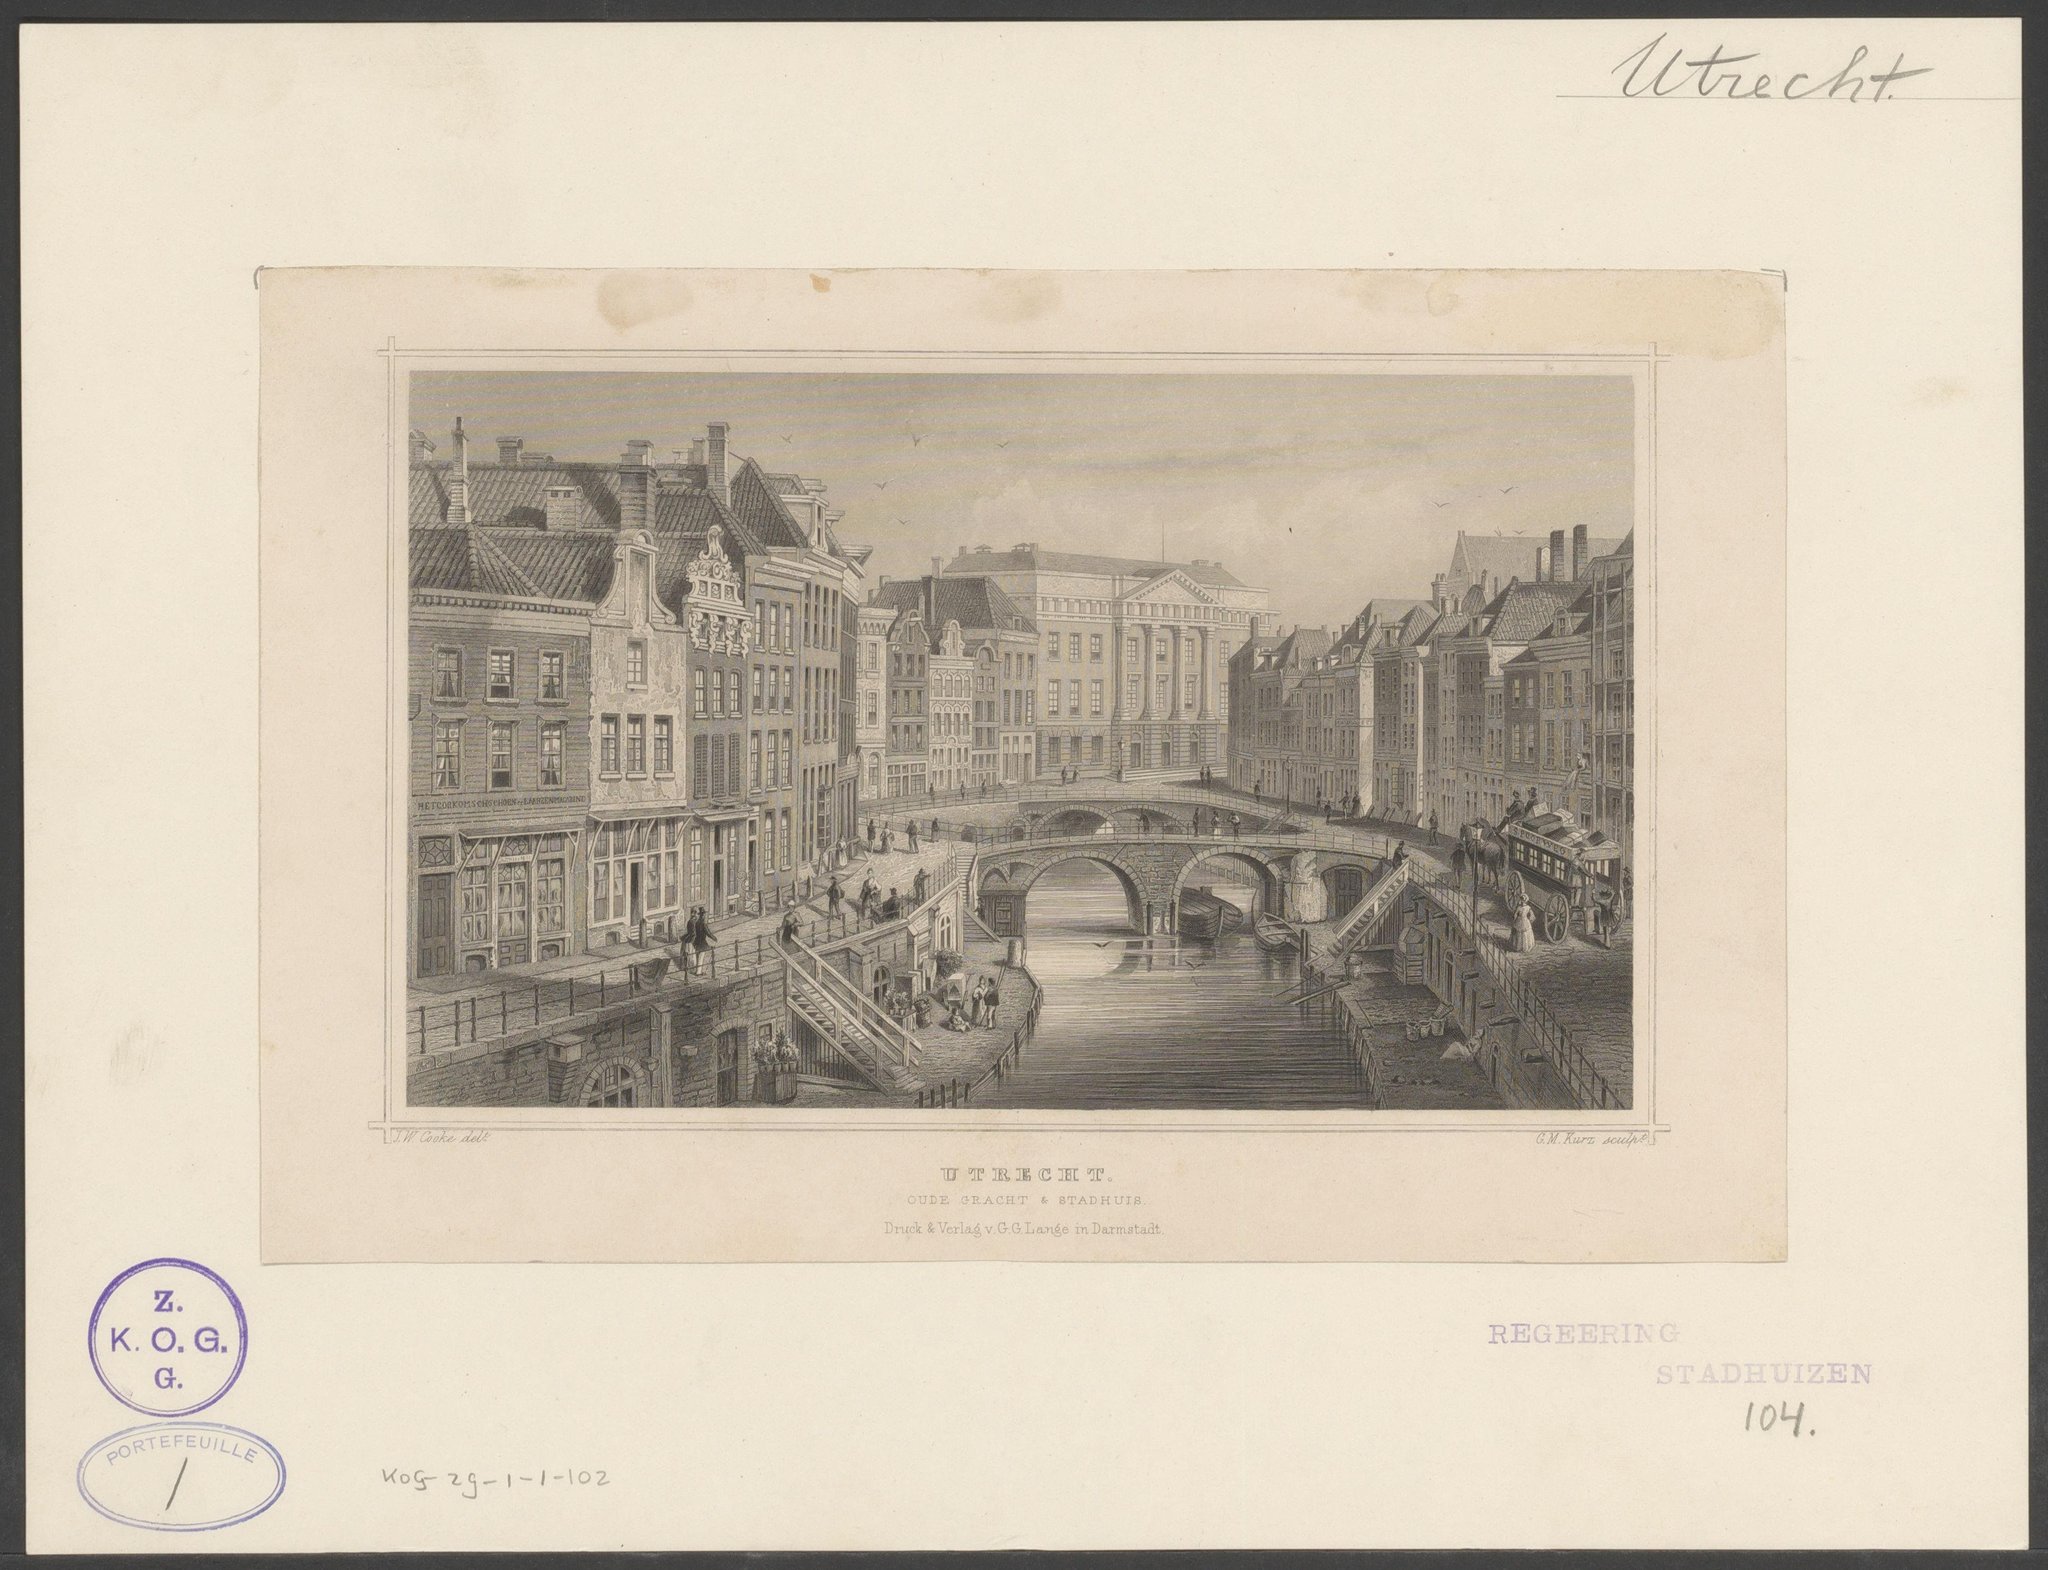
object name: print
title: Utrecht. Oude Gracht & Stadhuis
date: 1855-1857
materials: paper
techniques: engraving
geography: darmstadt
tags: townhall, canals, waters (in city), utrecht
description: Prent uit: Terwen, J.L. Het koningrijk der Nederlanden (...). 2 dln. Gouda: G.B. van Goor, 1857. Dezelfde prent, met een ander onderschrift, komt ook voor in: Der Rhein und die Rheinlande in malerischen Original-ansichten. 3 dln. Darmstadt: G.G. Lange, 1863.